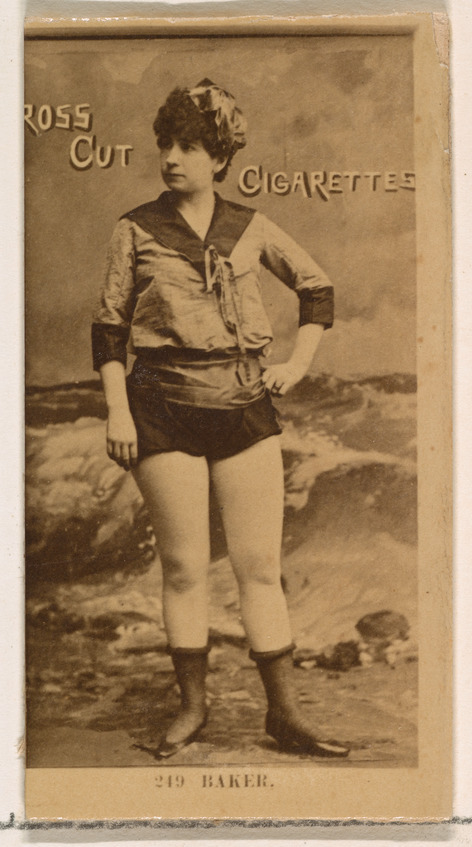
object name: print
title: Card Number 249, Baker, from the Actors and Actresses series (N145-2) issued by Duke Sons & Co. to promote Cross Cut Cigarettes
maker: w. duke, sons & co.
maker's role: publisher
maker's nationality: american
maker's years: 1870-1920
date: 1880-1889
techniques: albumen silver print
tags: portraits,women,actresses